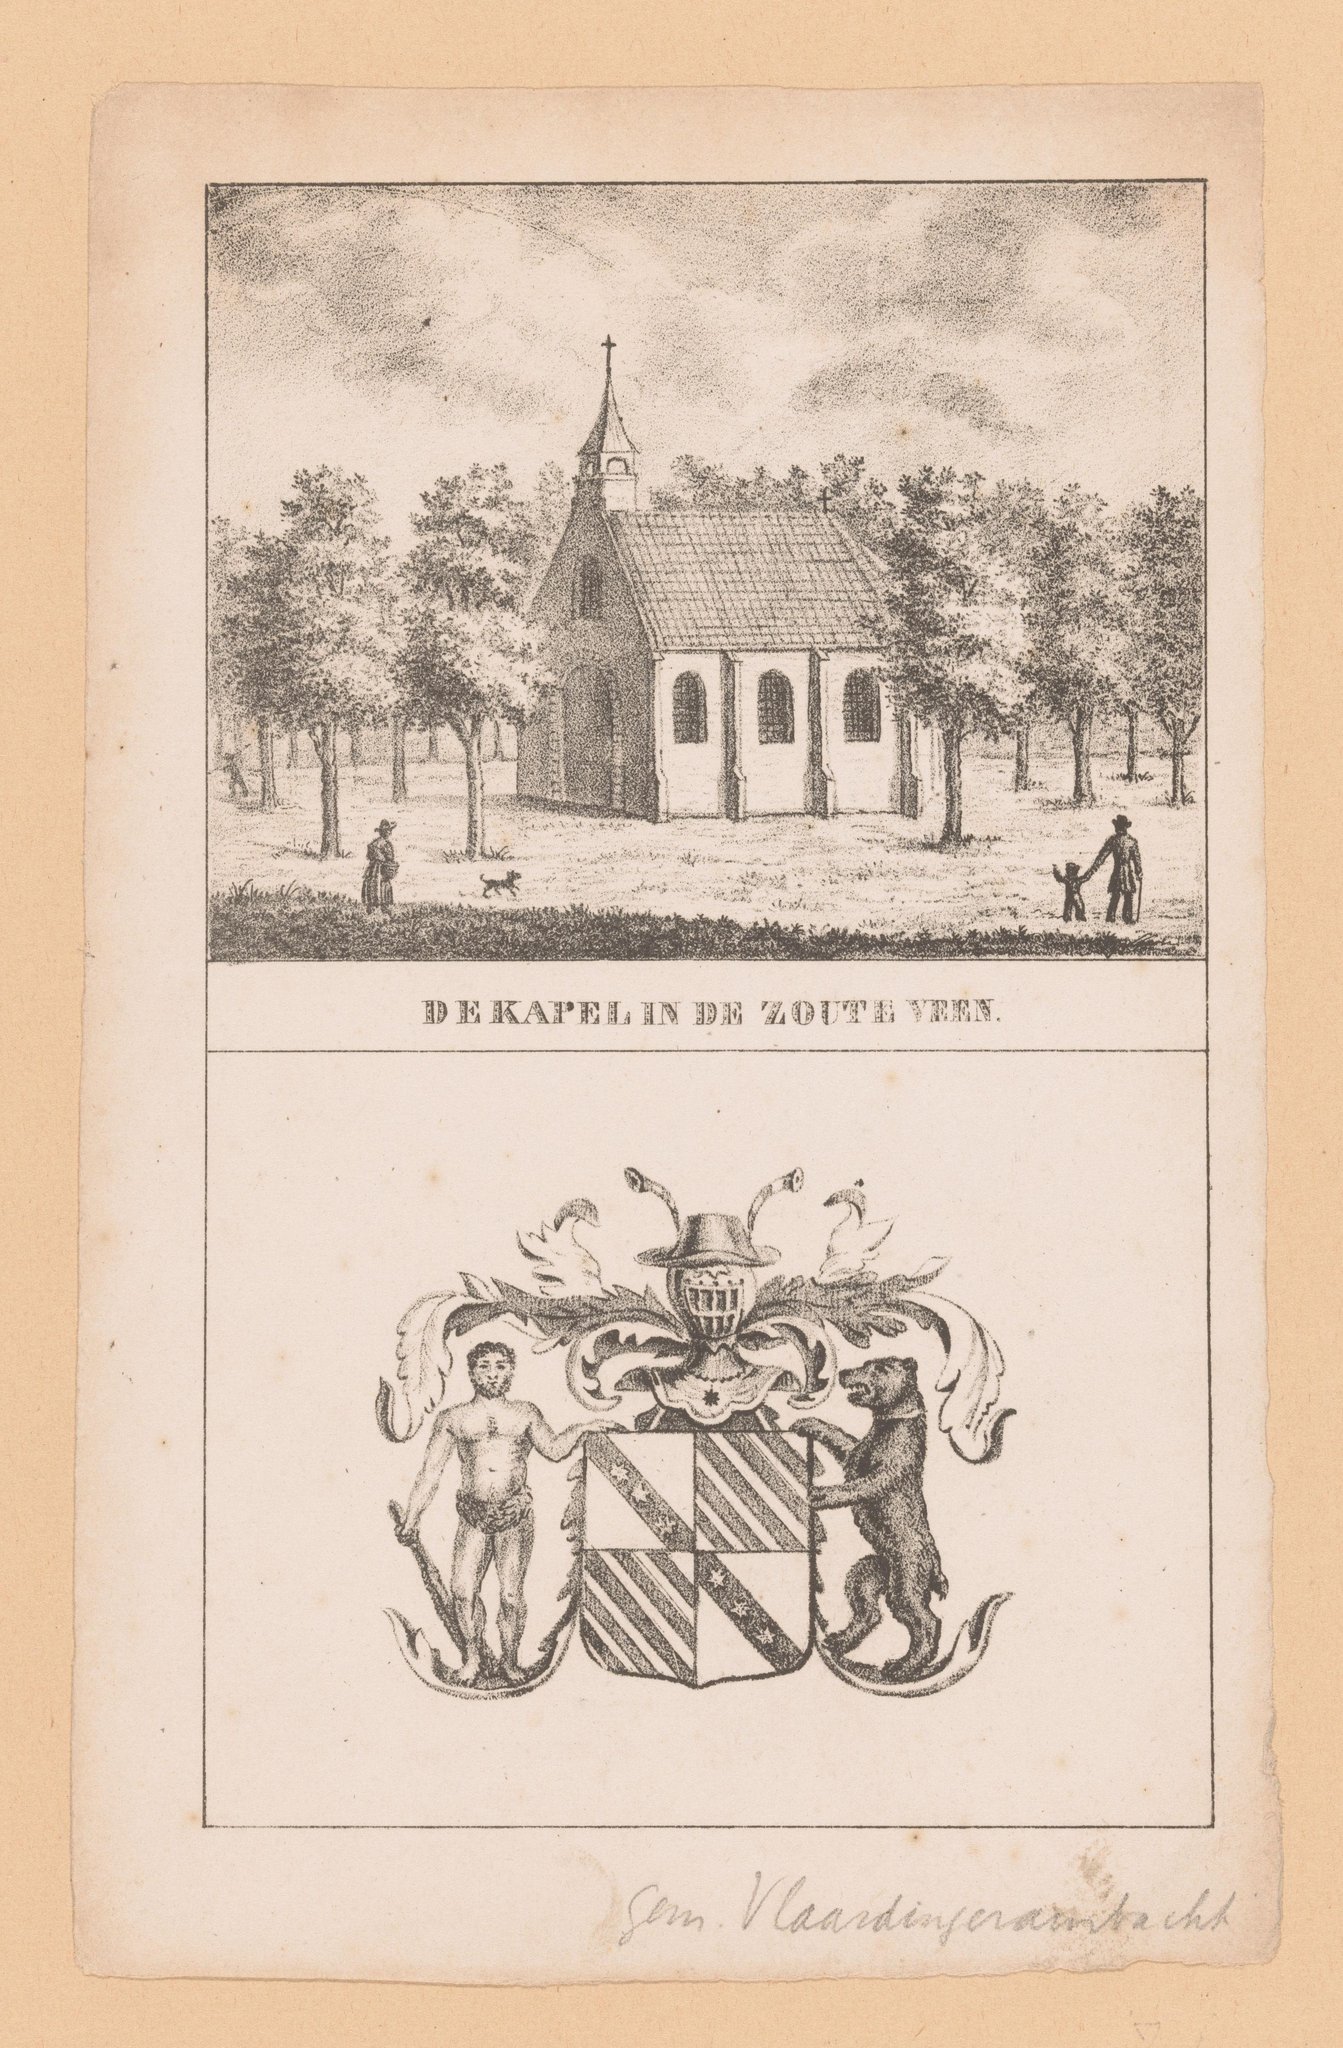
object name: print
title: De kapel in de Zoute Veen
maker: Anonymous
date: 1800-1850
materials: paper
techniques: lithograph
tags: church (exterior)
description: Afbeelding van de kapel in Zouteveen met daaronder een afbeelding van een wapenschild.